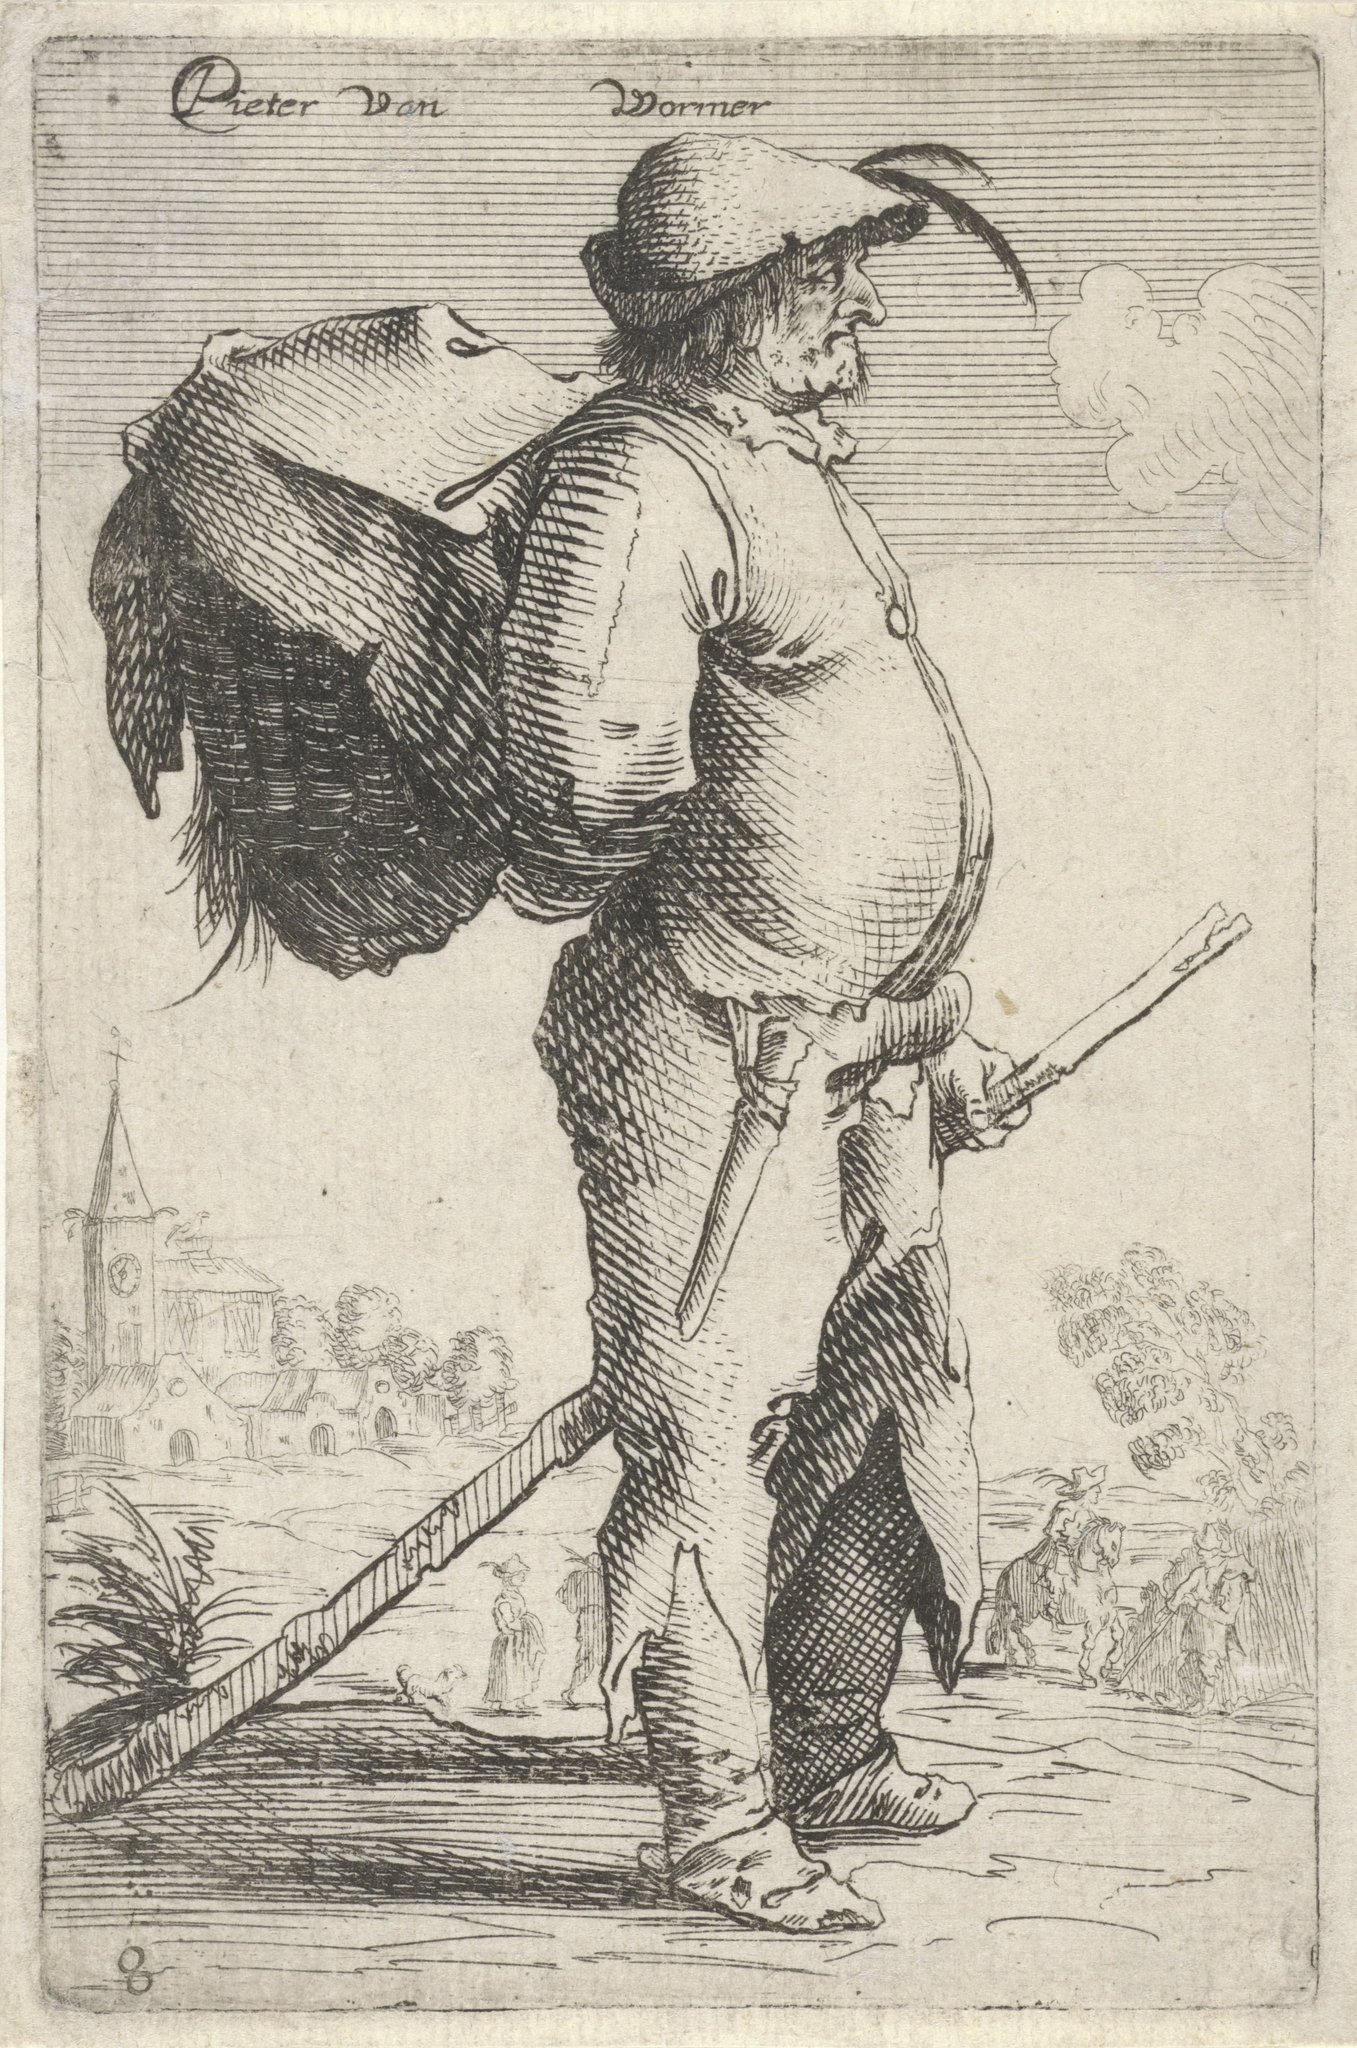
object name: print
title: Man met rugzak en stok, gezien en profil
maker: Anonymous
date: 1630-1715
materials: paper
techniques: engraving, etching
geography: amsterdam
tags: farmers, carrying something in basket, bag, rucksack, etc.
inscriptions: collector's mark: Lugt 2228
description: Kopie naar prent uit de twaalfdelige serie "T'Leven Der Boeren" van Salomon Savery naar Pieter Jansz. Quast.